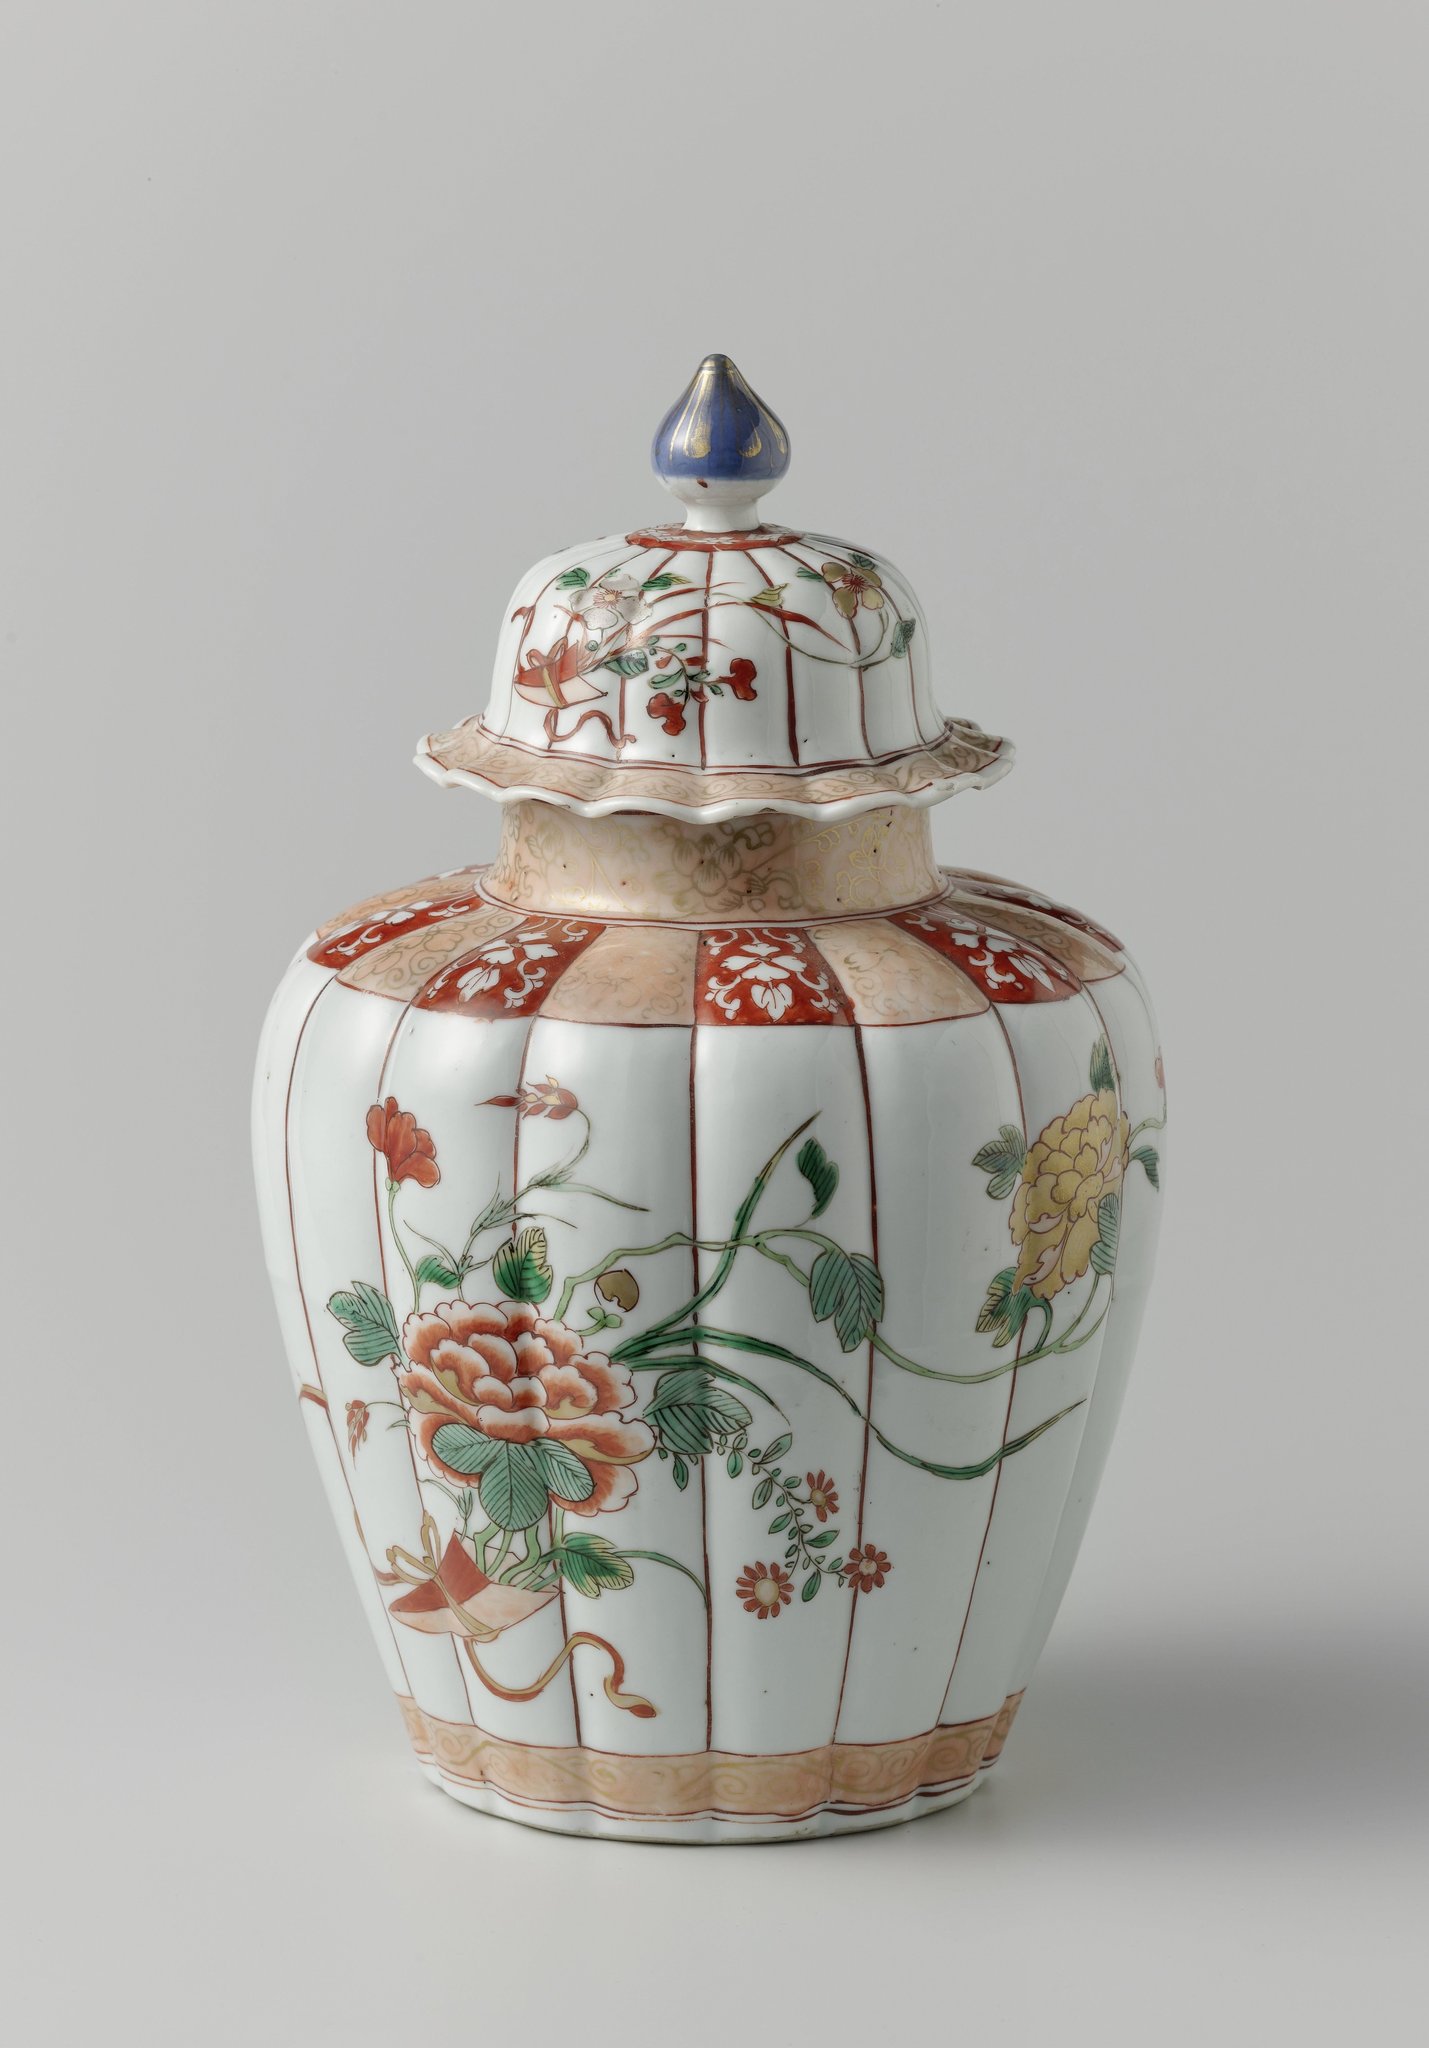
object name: covered jar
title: Lobed covered jar with two bouquets and flower scrolls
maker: Anonymous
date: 1725-1735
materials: cobalt, glaze, gold, paint, porcelain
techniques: forming, gilding, turning, vitrification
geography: china